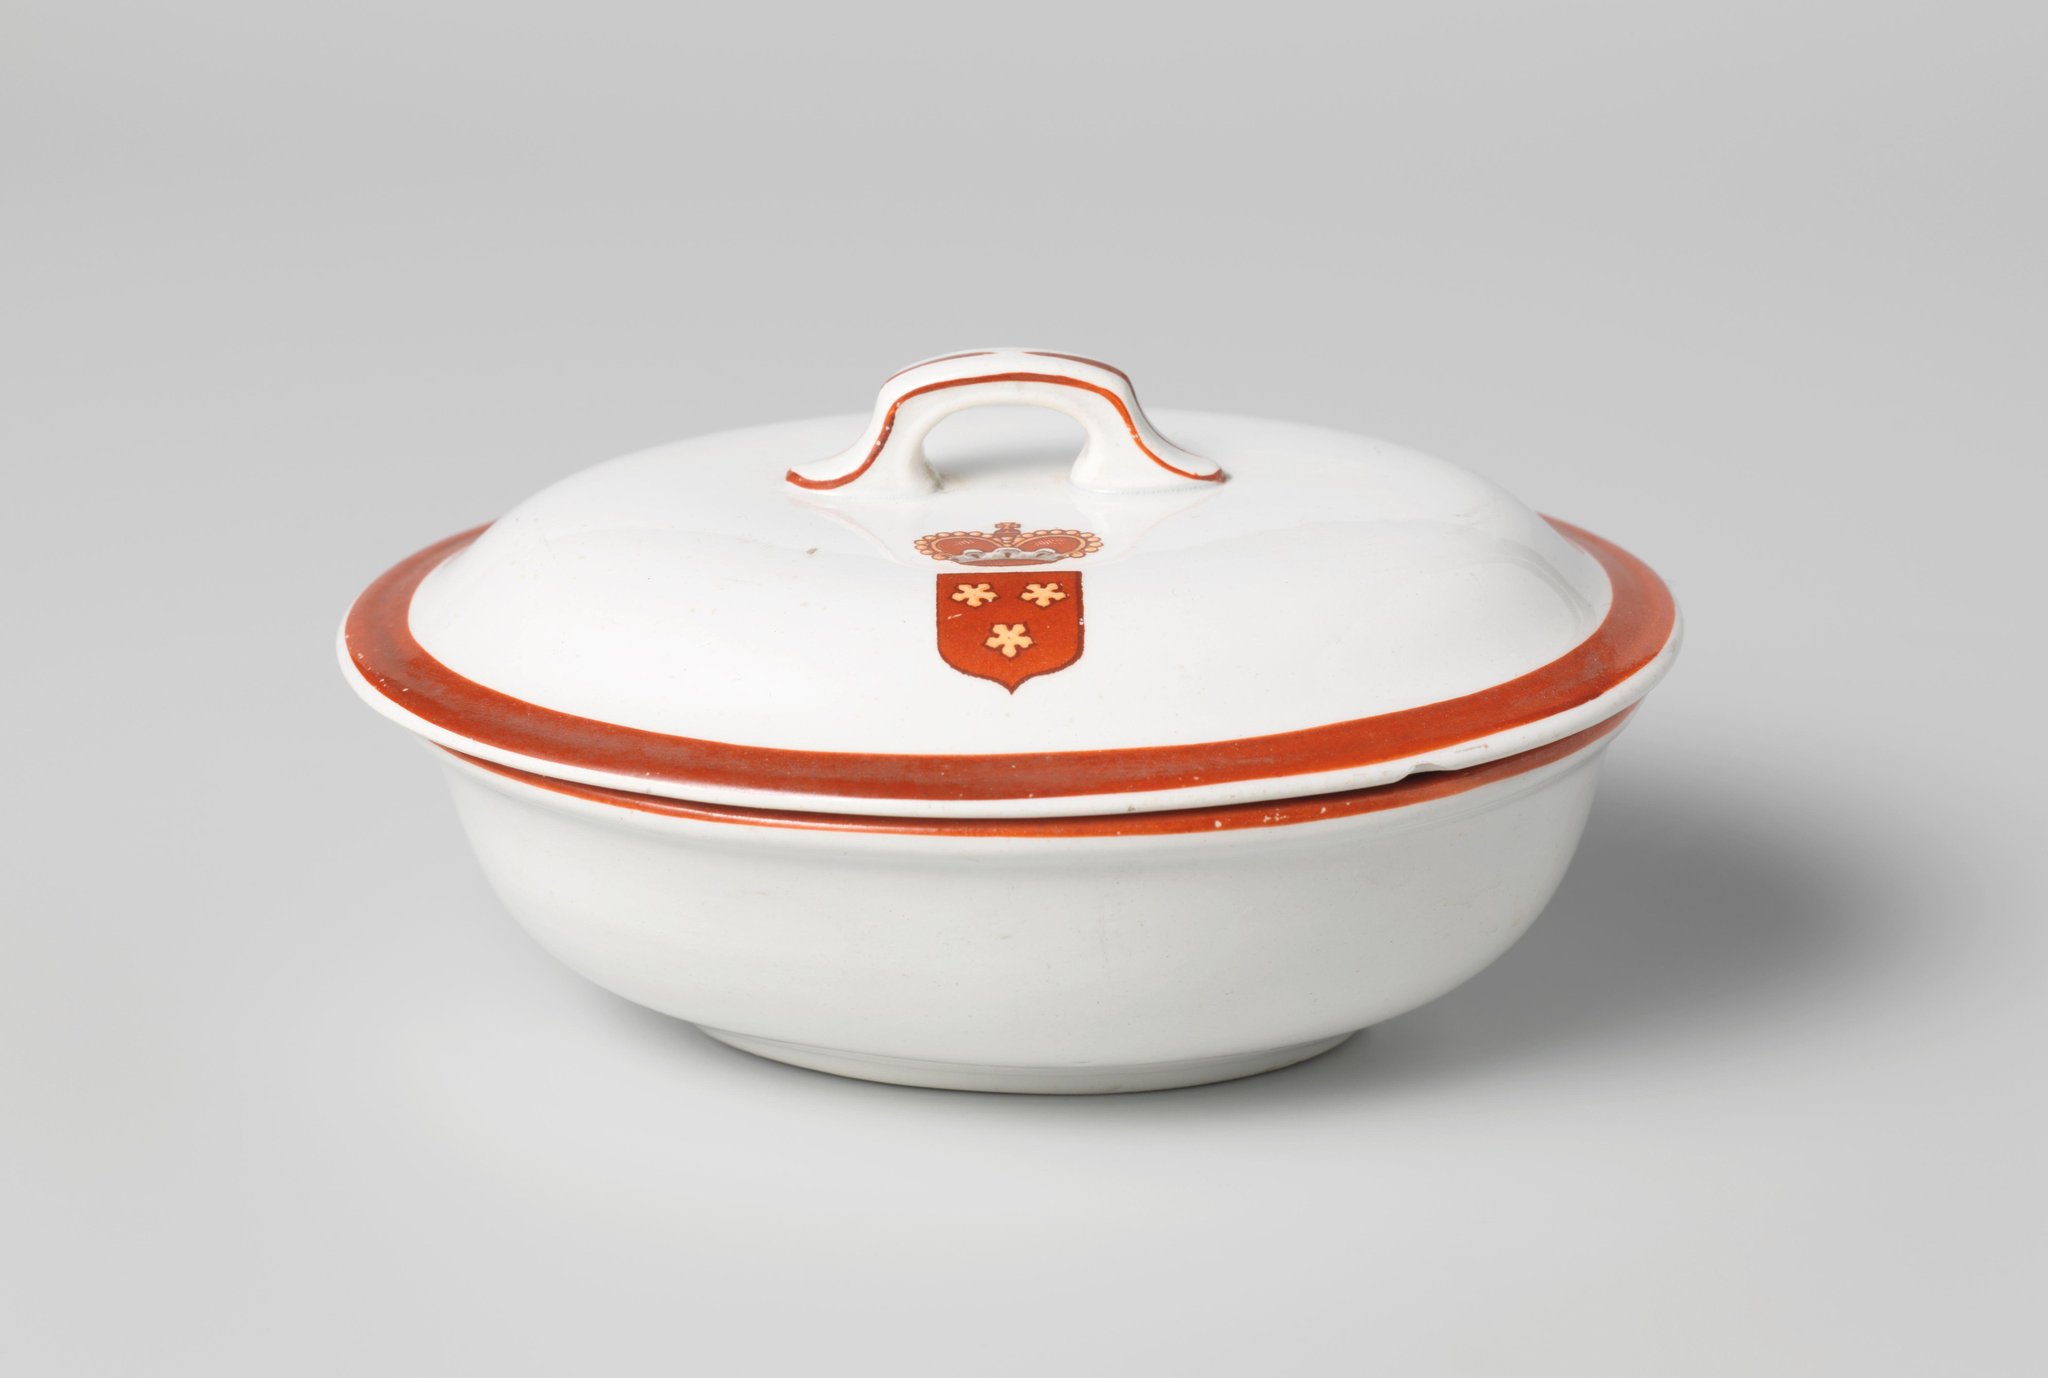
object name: soap dish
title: Zeepbak, deel van een toiletgarnituur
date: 1874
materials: earthenware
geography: wallerfangen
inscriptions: mark: ‘beeldmerk Villeroy & Boch van van 1874’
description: Zeepbak met deksel, deel van een toiletgarnituur van aardewerk. Versierd met rode biezen en het wapen van de Hertog van Arenberg met kroon in rood en geel.